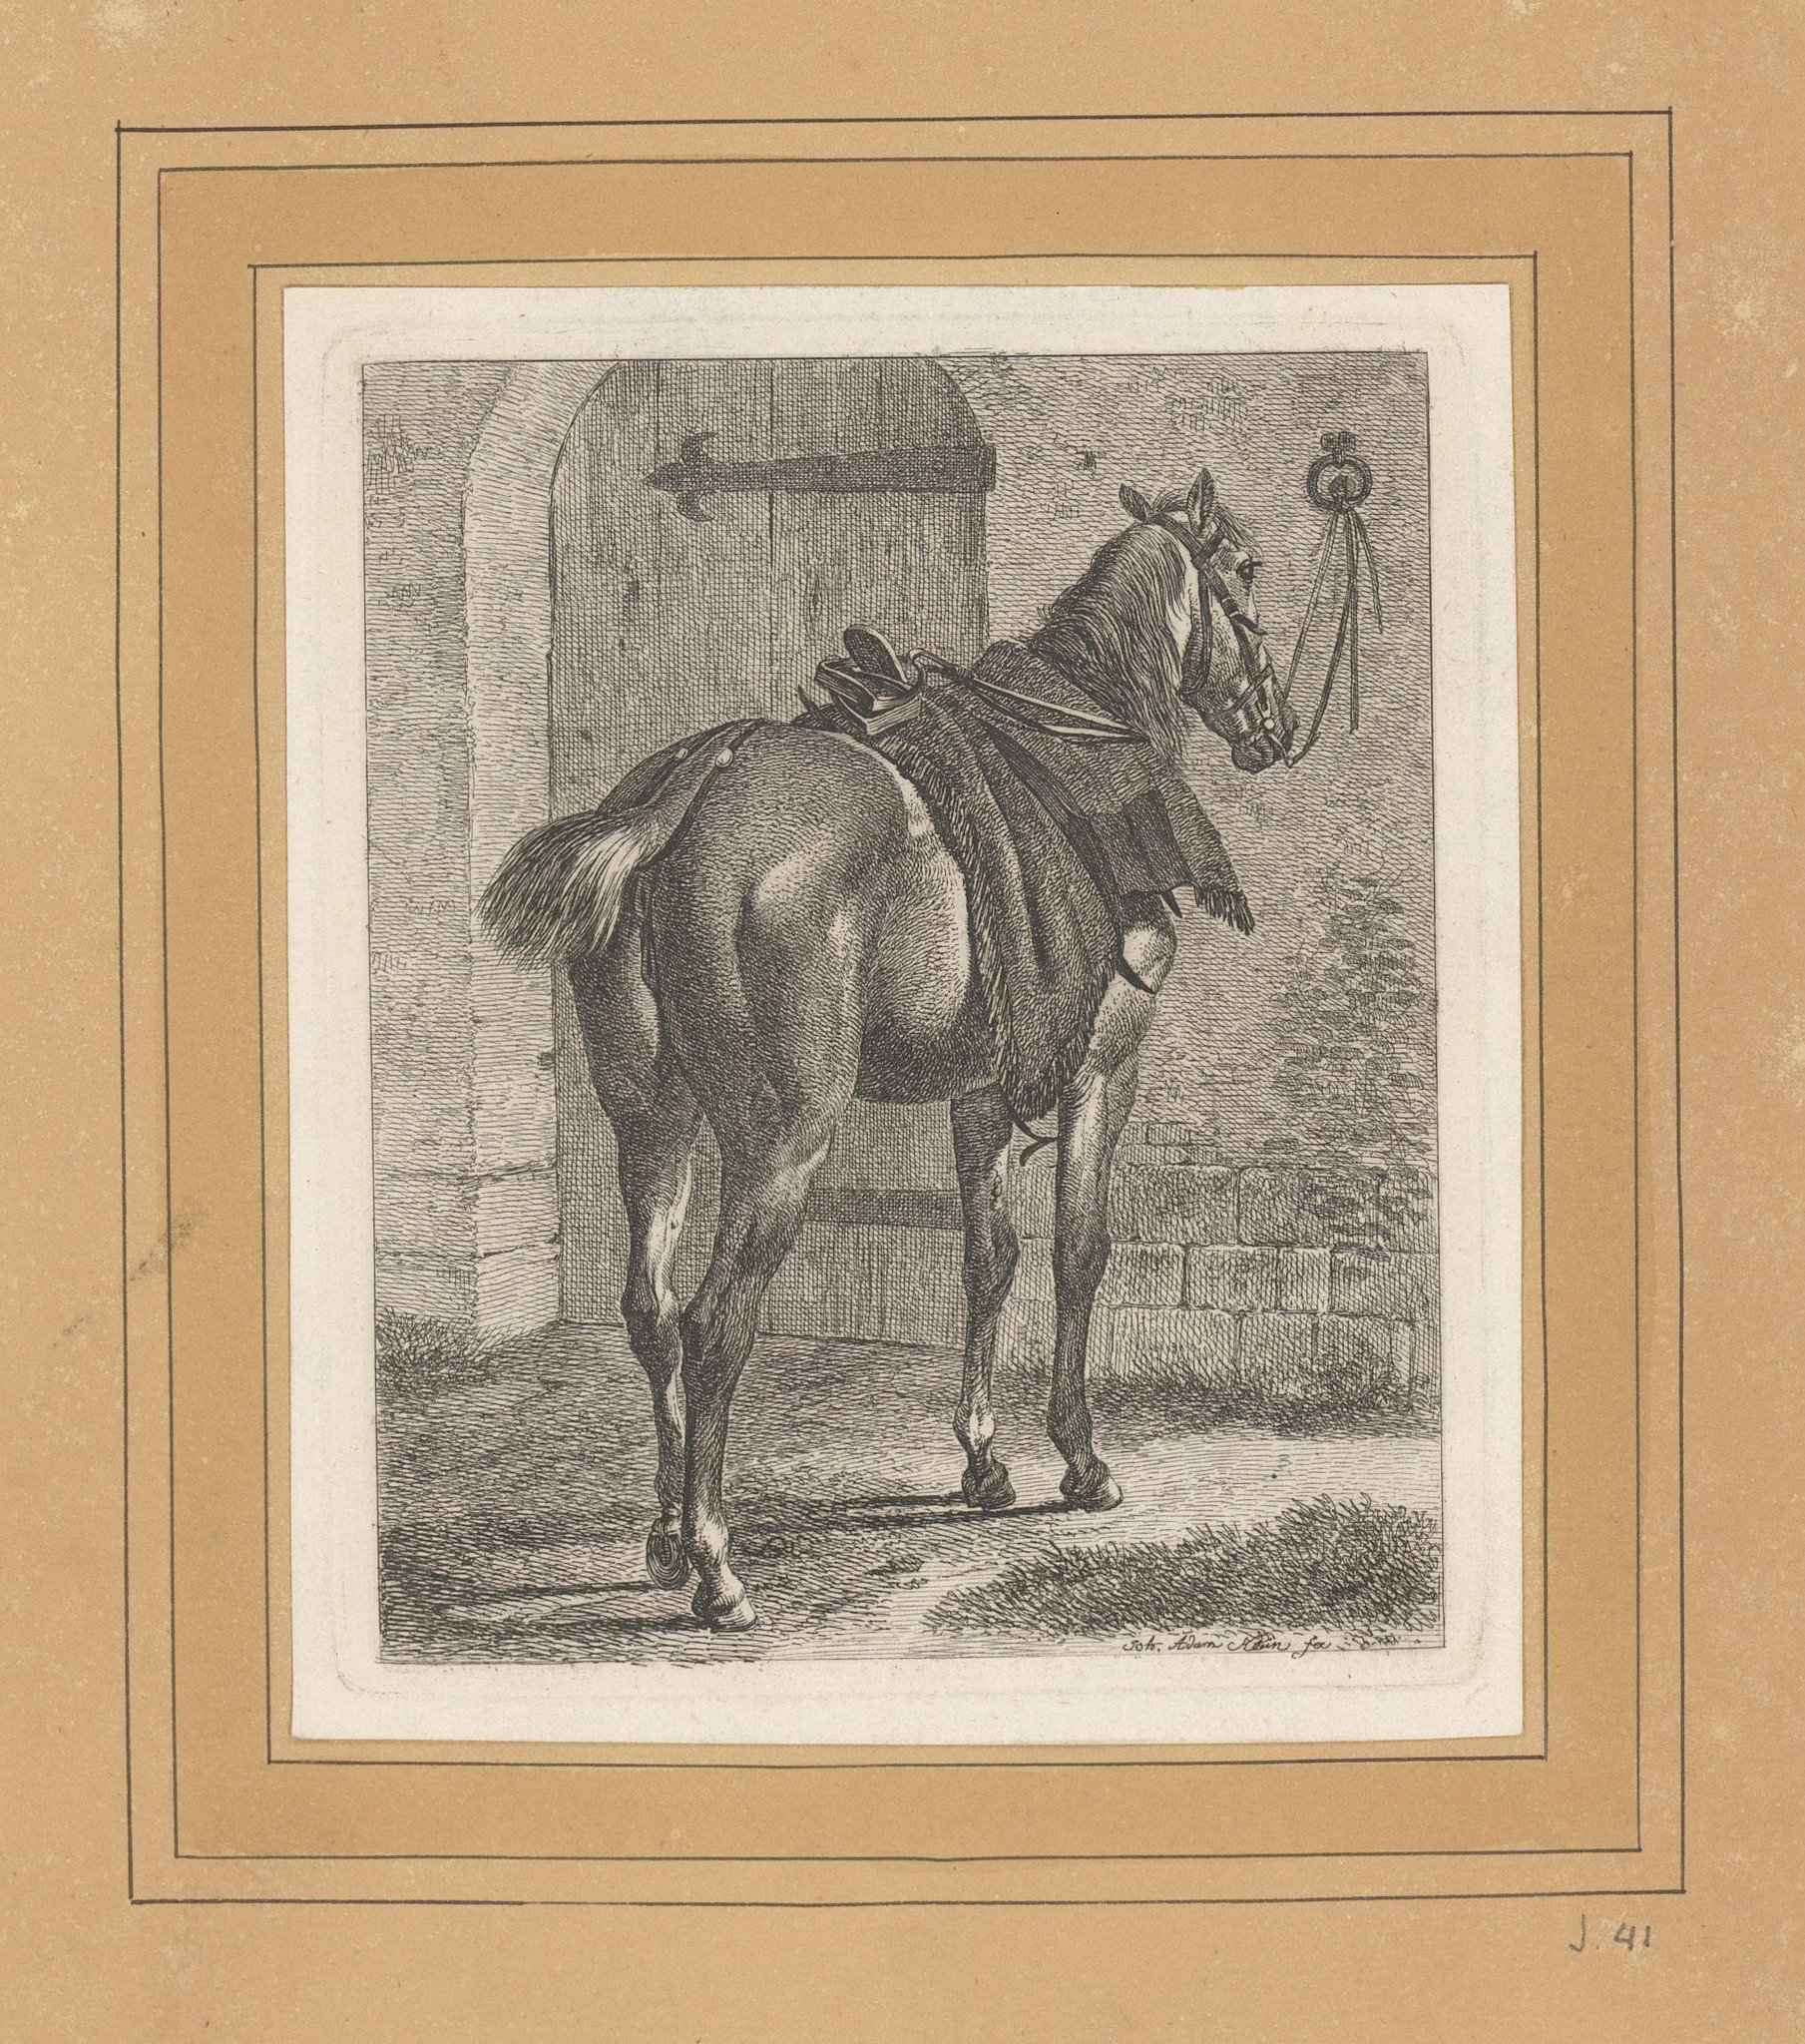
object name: album leaf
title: Trekpaard aan muurring aangelijnd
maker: johann adam klein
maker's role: draughtsman, print maker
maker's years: 1792-1875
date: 1808-1814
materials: paper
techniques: etching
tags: hitching up, harnessing ~ animal traction, horse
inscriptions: collector's mark: Lugt 2760, collector's mark: Lugt 2228